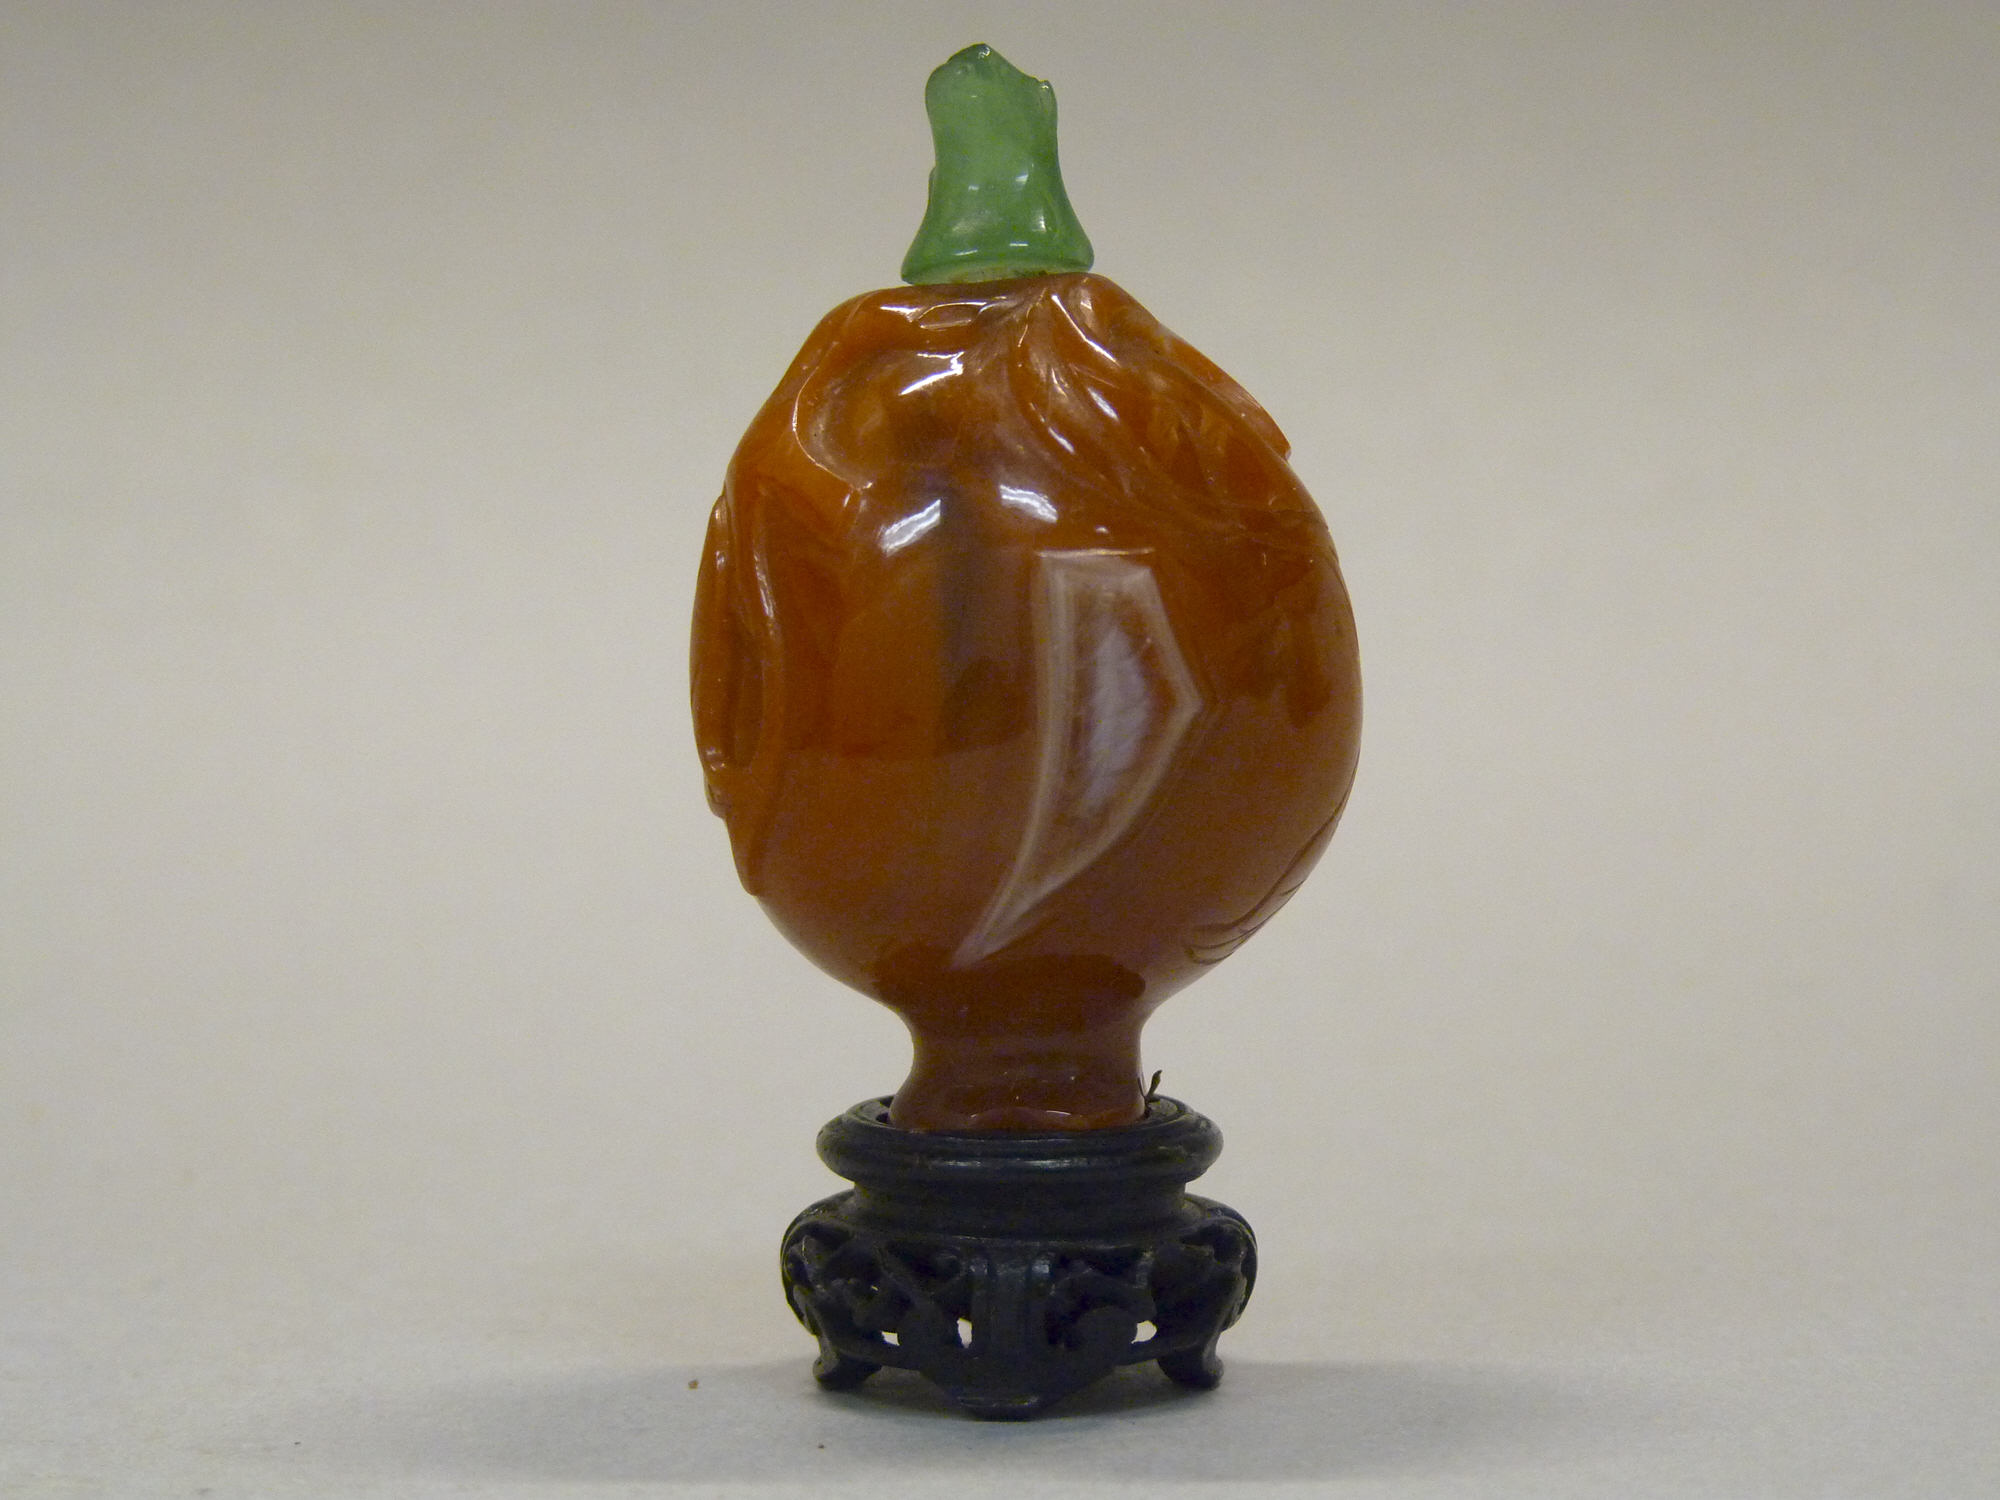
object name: snuff bottle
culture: chinese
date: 1736-1795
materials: stone, gemstone, glass